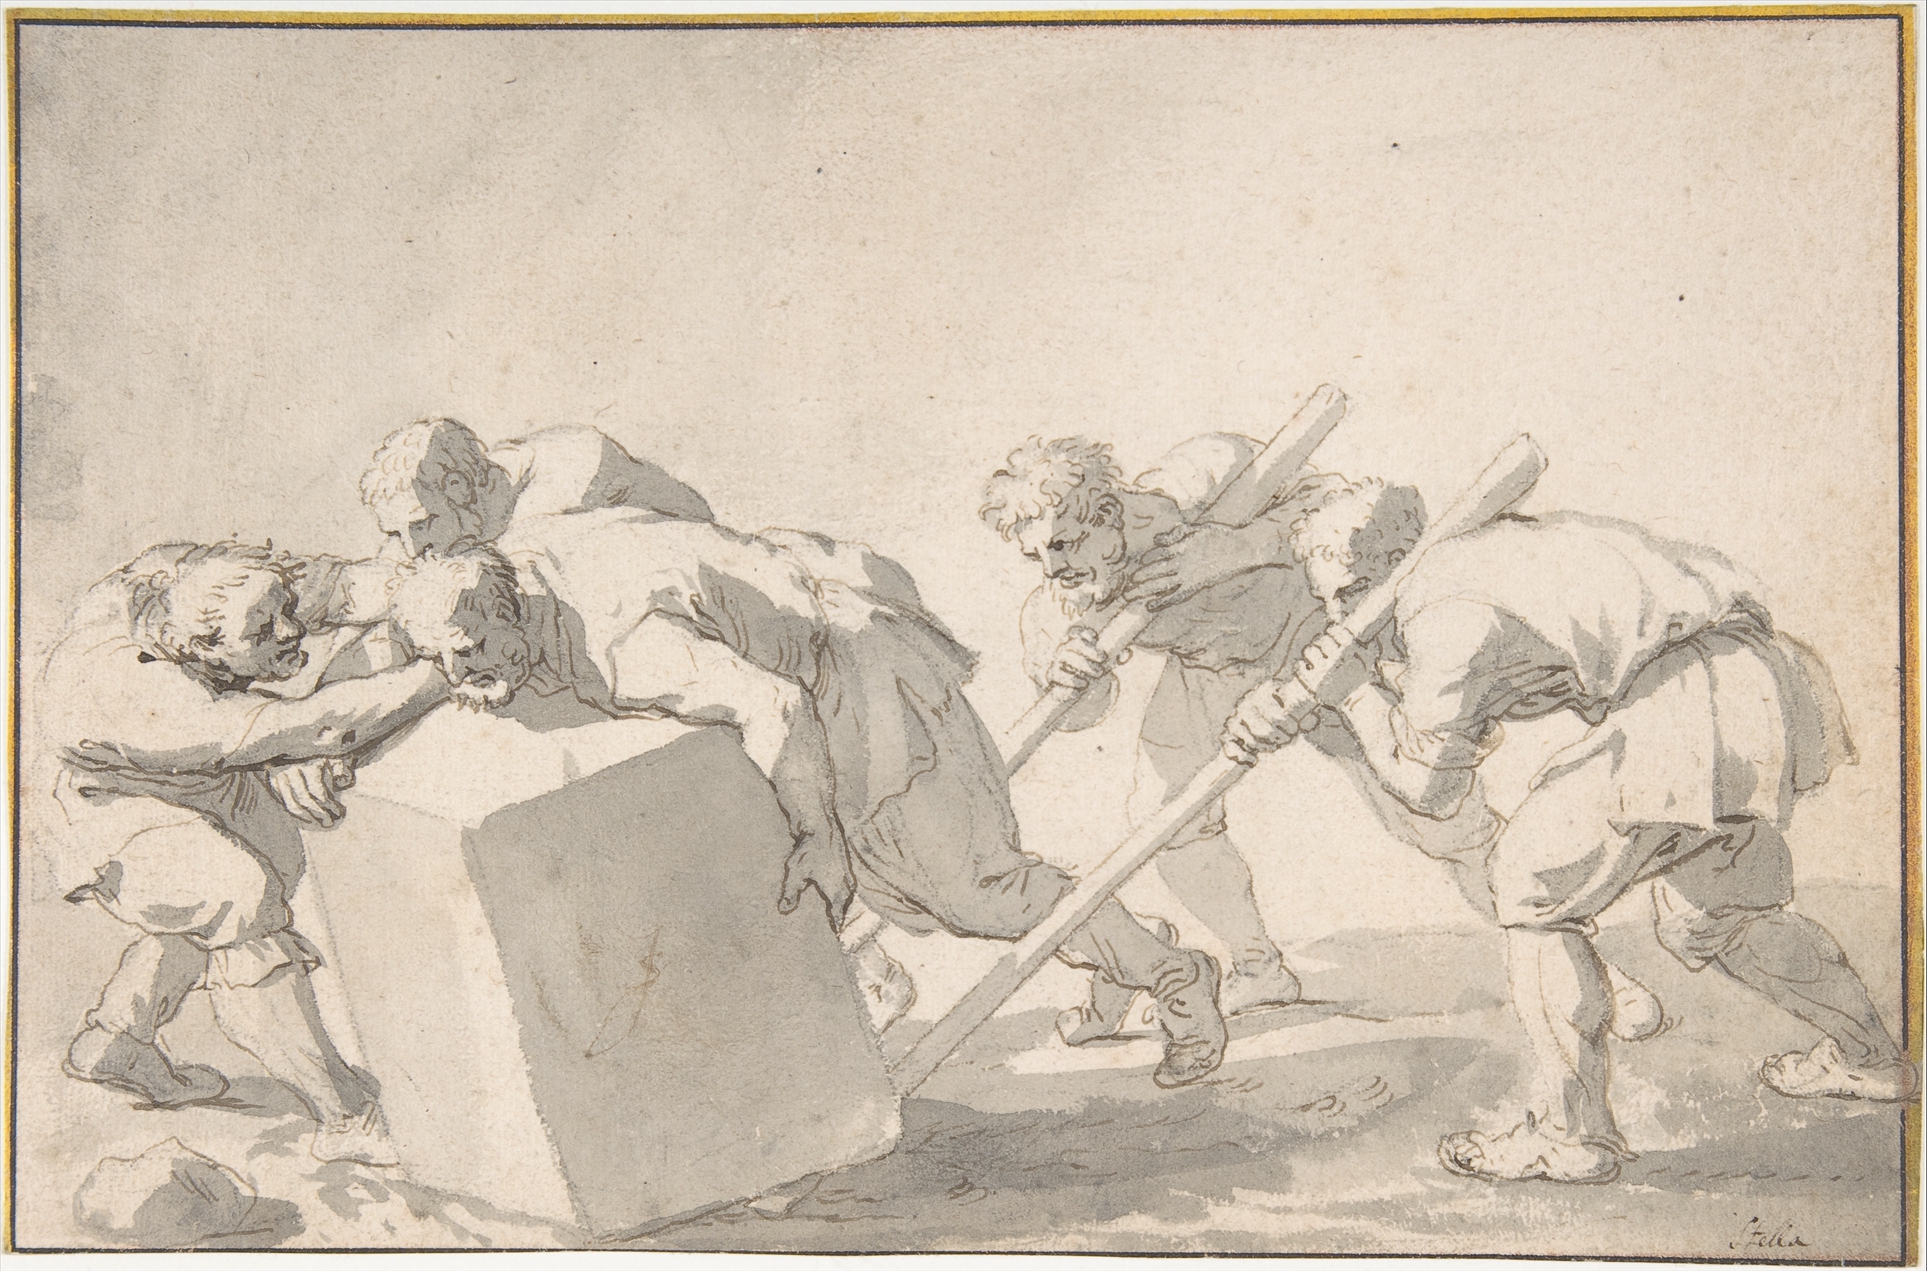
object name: drawing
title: Five Men Pushing a Block of Stone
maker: jacques stella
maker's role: artist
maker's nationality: french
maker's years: 1596-1657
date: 1640-1650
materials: chalk, ink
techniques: brush, pen, wash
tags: men,working